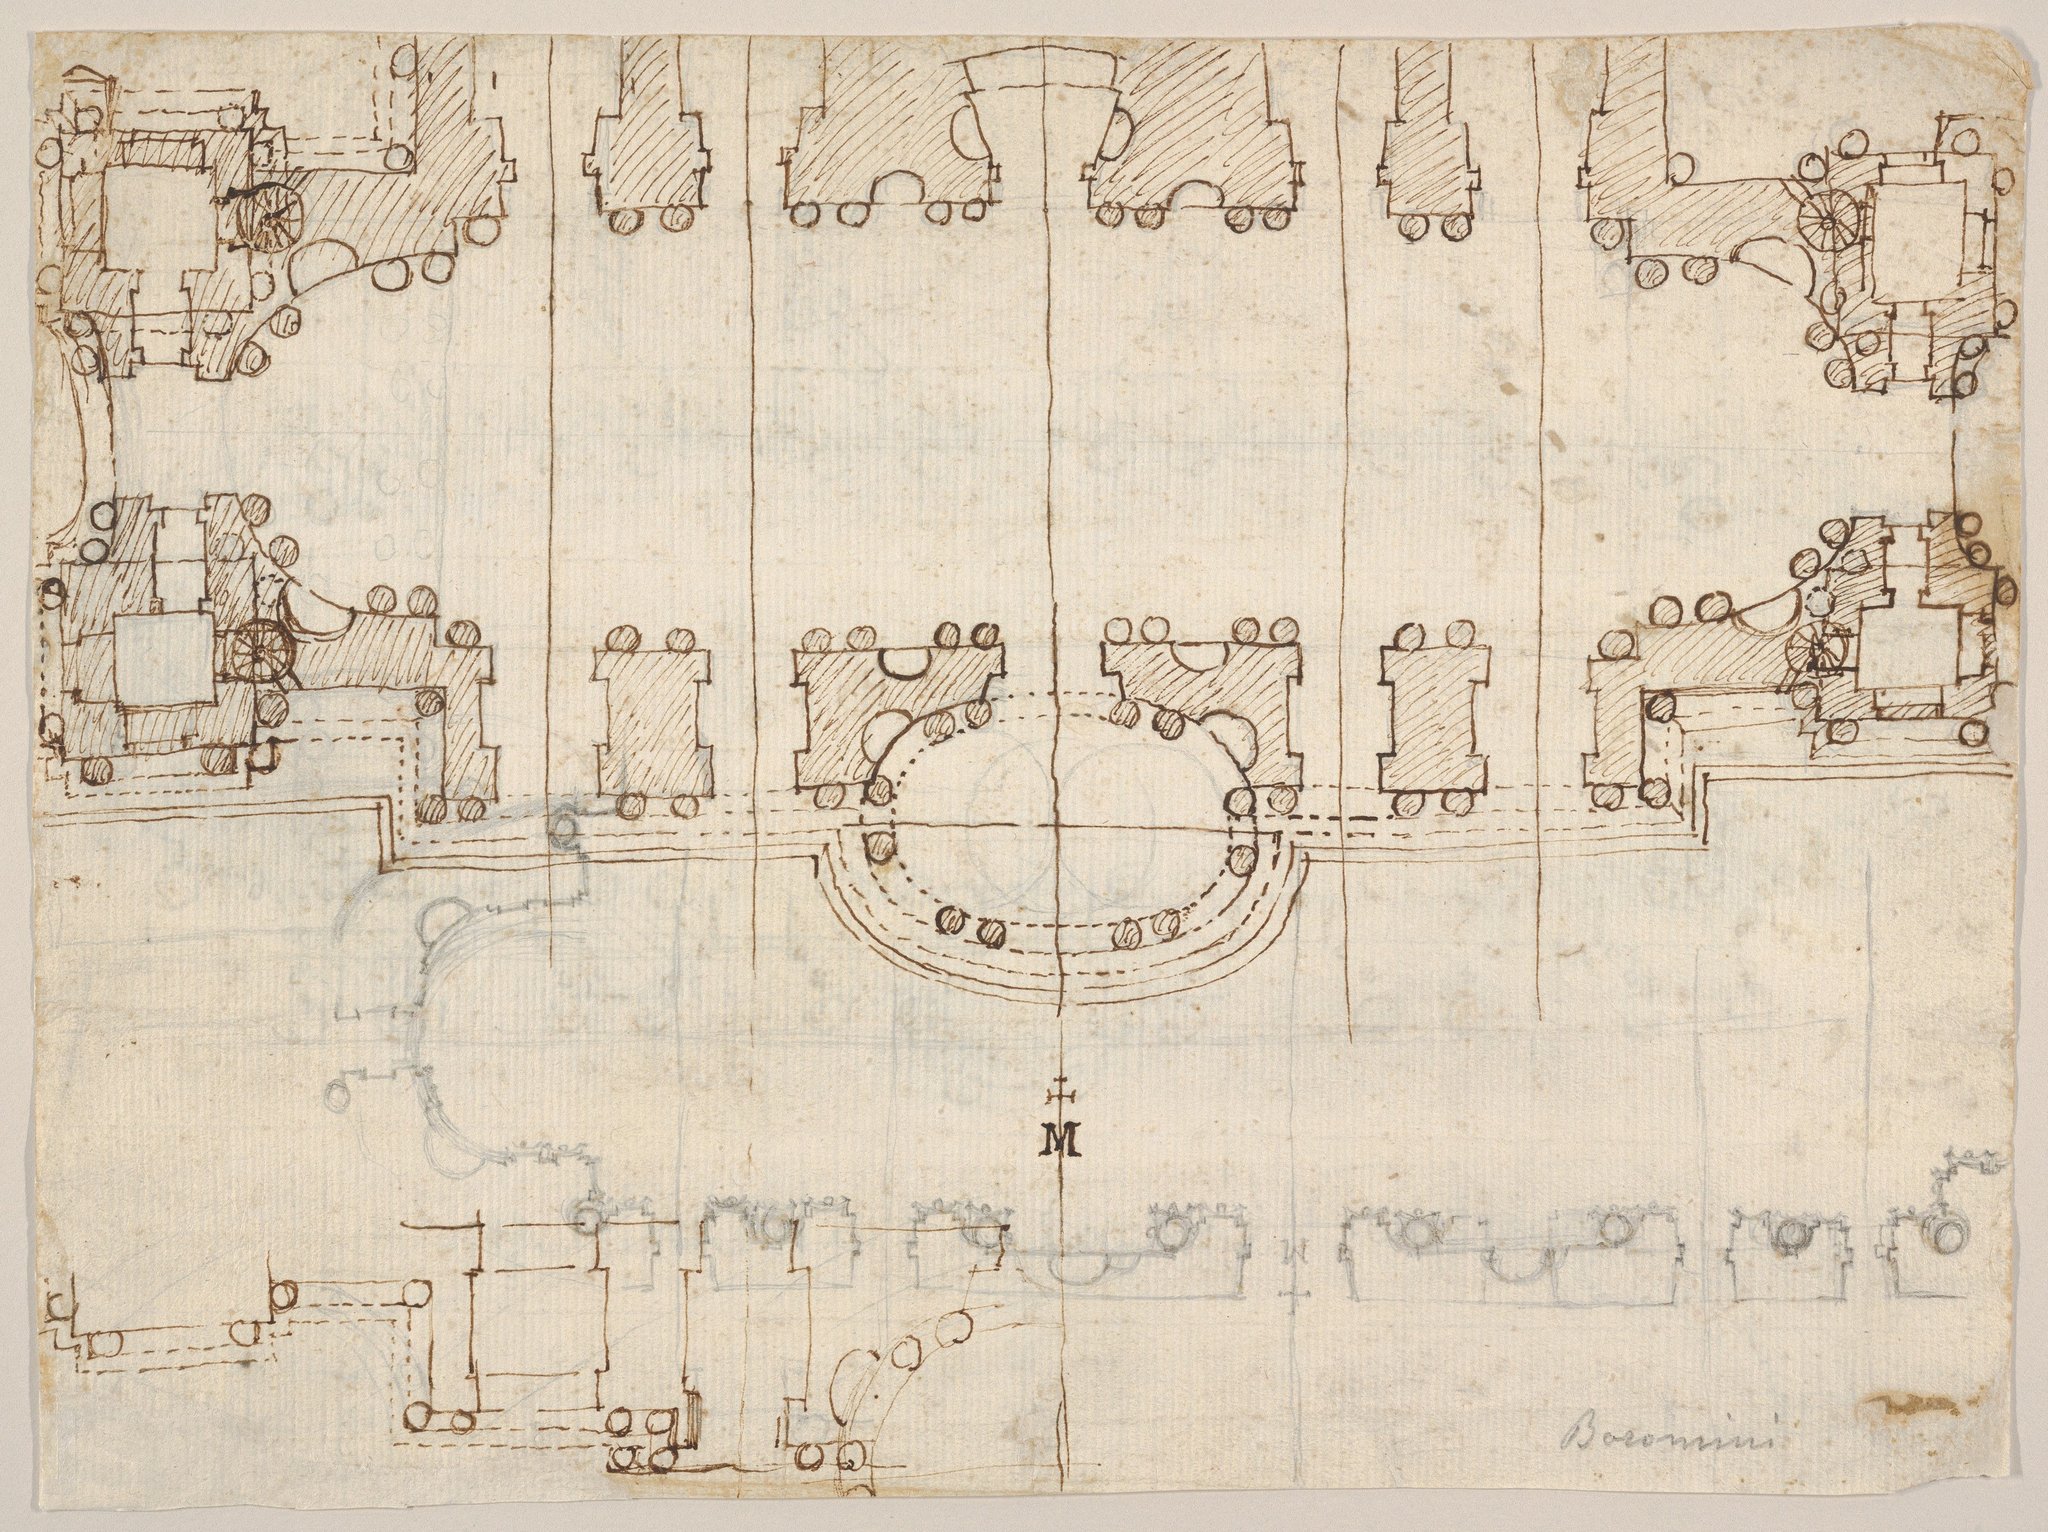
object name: drawing ornament architecture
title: Studies for the Nave and Narthex of San Giovanni in Laterano, Rome (recto and verso)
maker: francesco borromini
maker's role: artist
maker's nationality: italian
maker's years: 1599-1667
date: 1646-1655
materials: chalk, ink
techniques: pen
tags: architecture